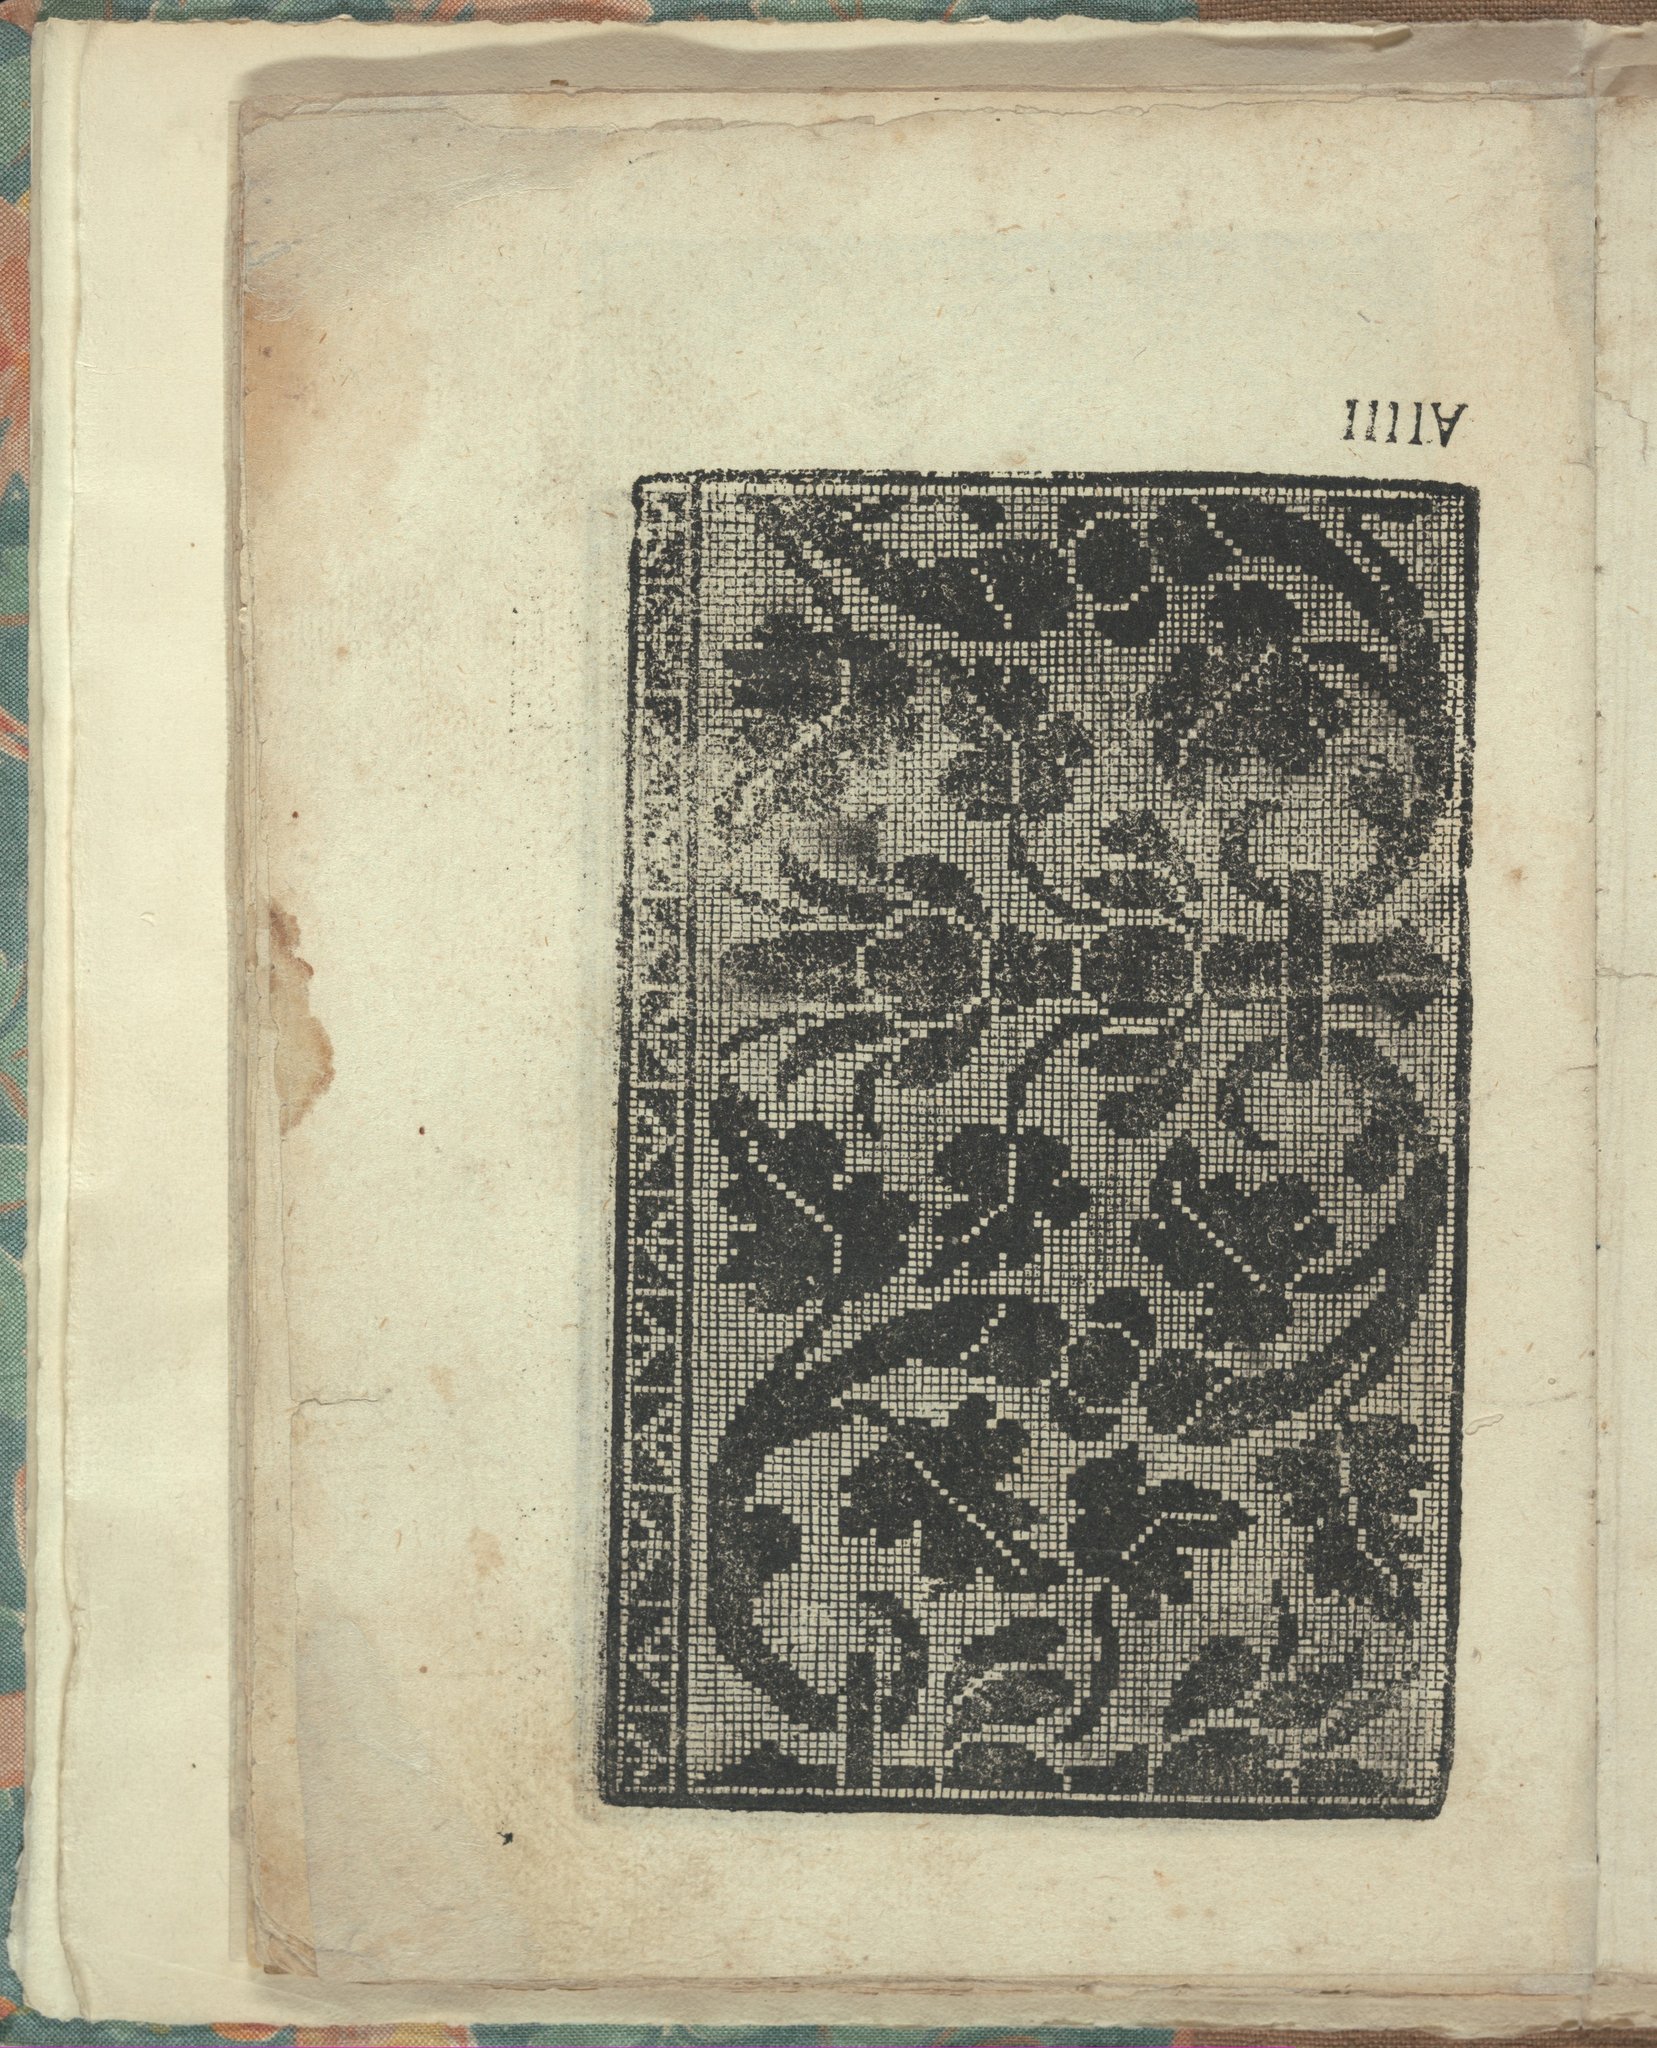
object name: book print ornament architecture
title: Opera Nova Universali intitulata Corona di racammi, page 24 (verso)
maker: giovanni andrea vavassore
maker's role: publisher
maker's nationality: italian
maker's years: 1530-1573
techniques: woodcut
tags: ornament